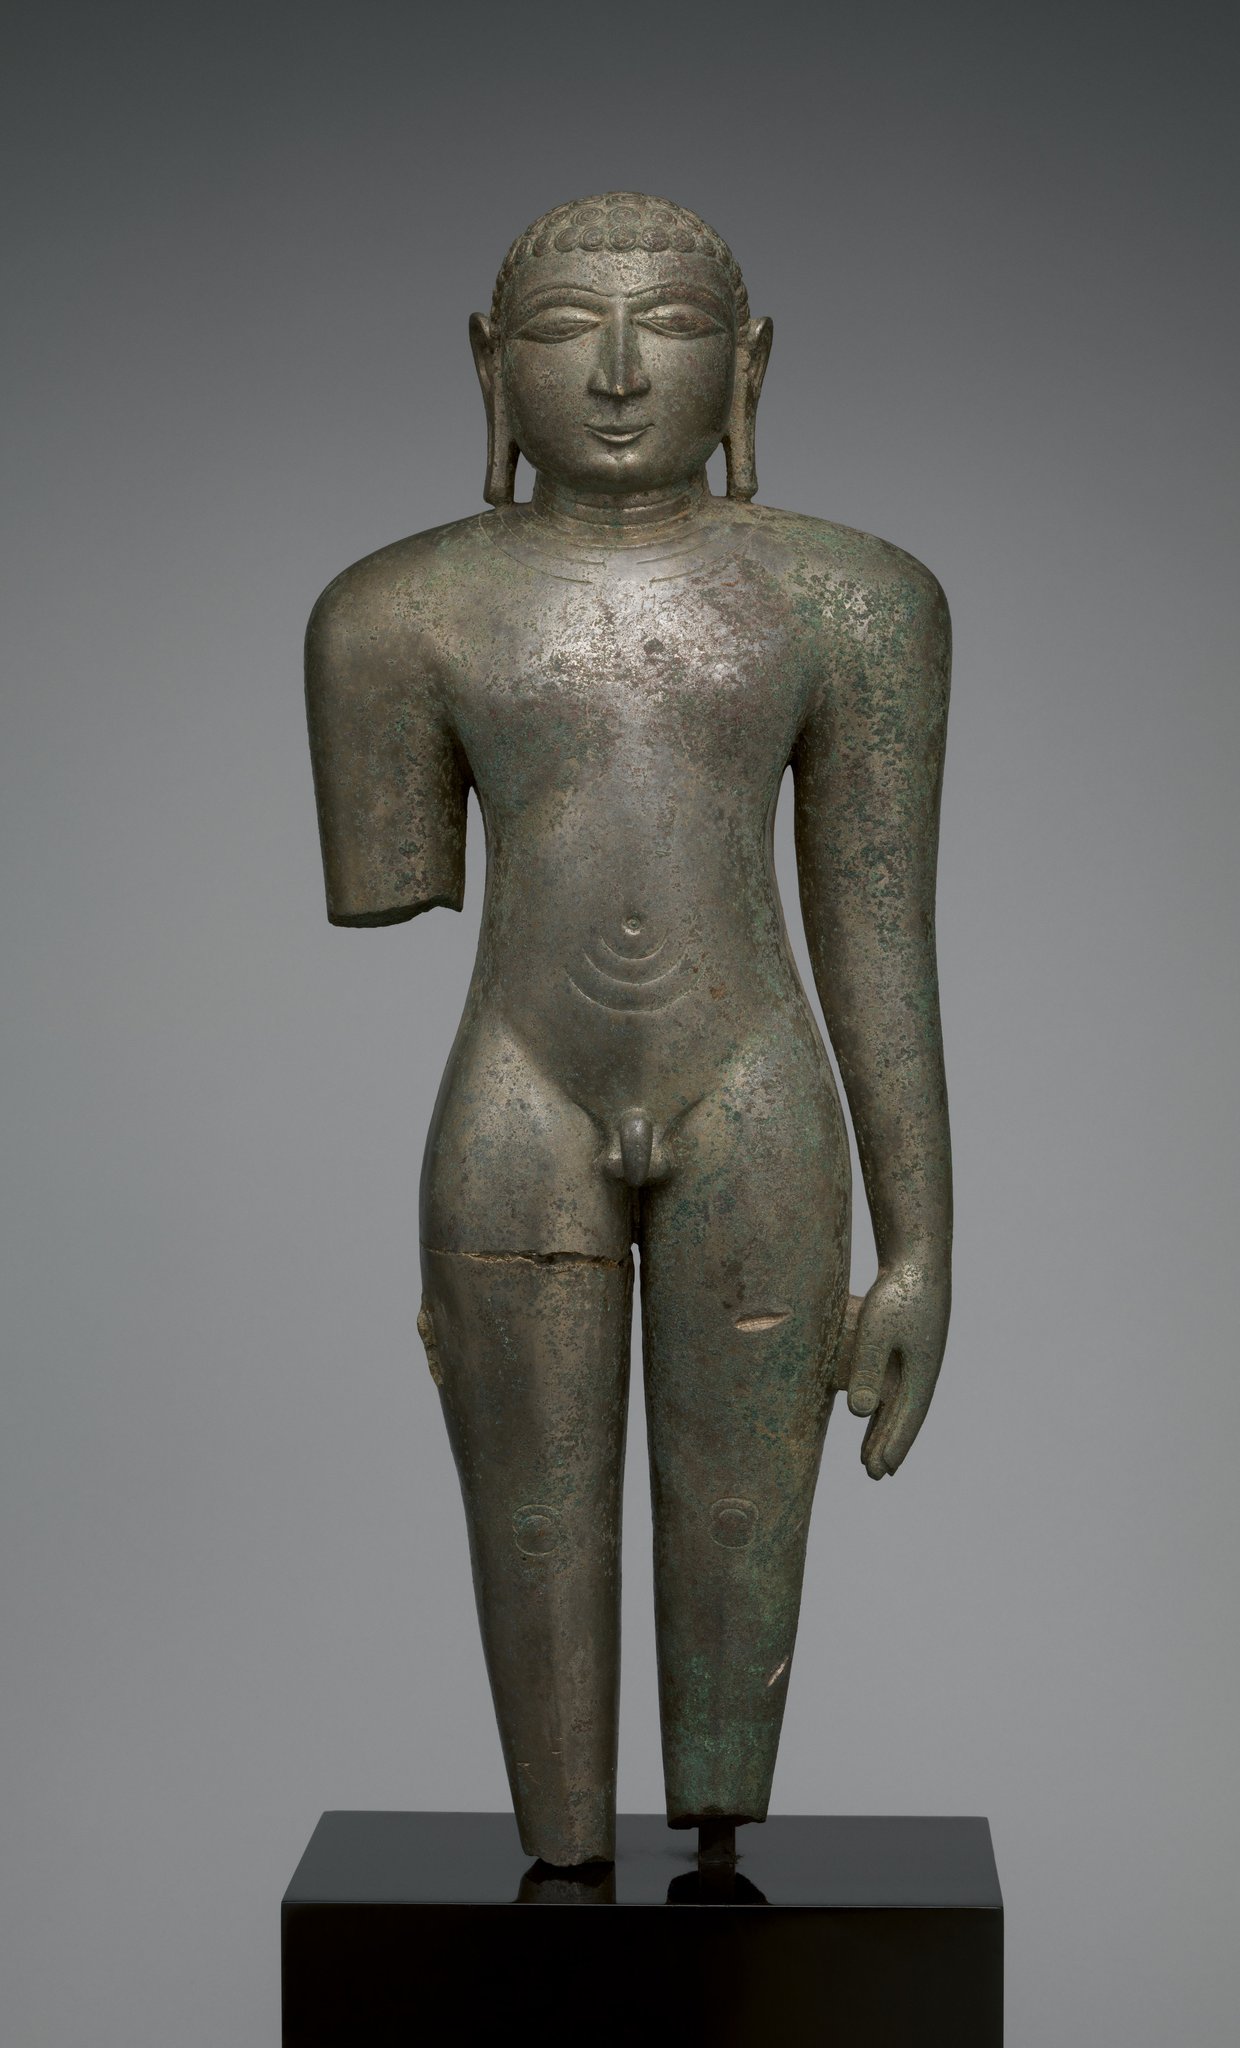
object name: figure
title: Jain Digambara Tirthanhara Standing in Kayotsarga Meditation Posture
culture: indian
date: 1101-1200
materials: copper alloy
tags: male nudes